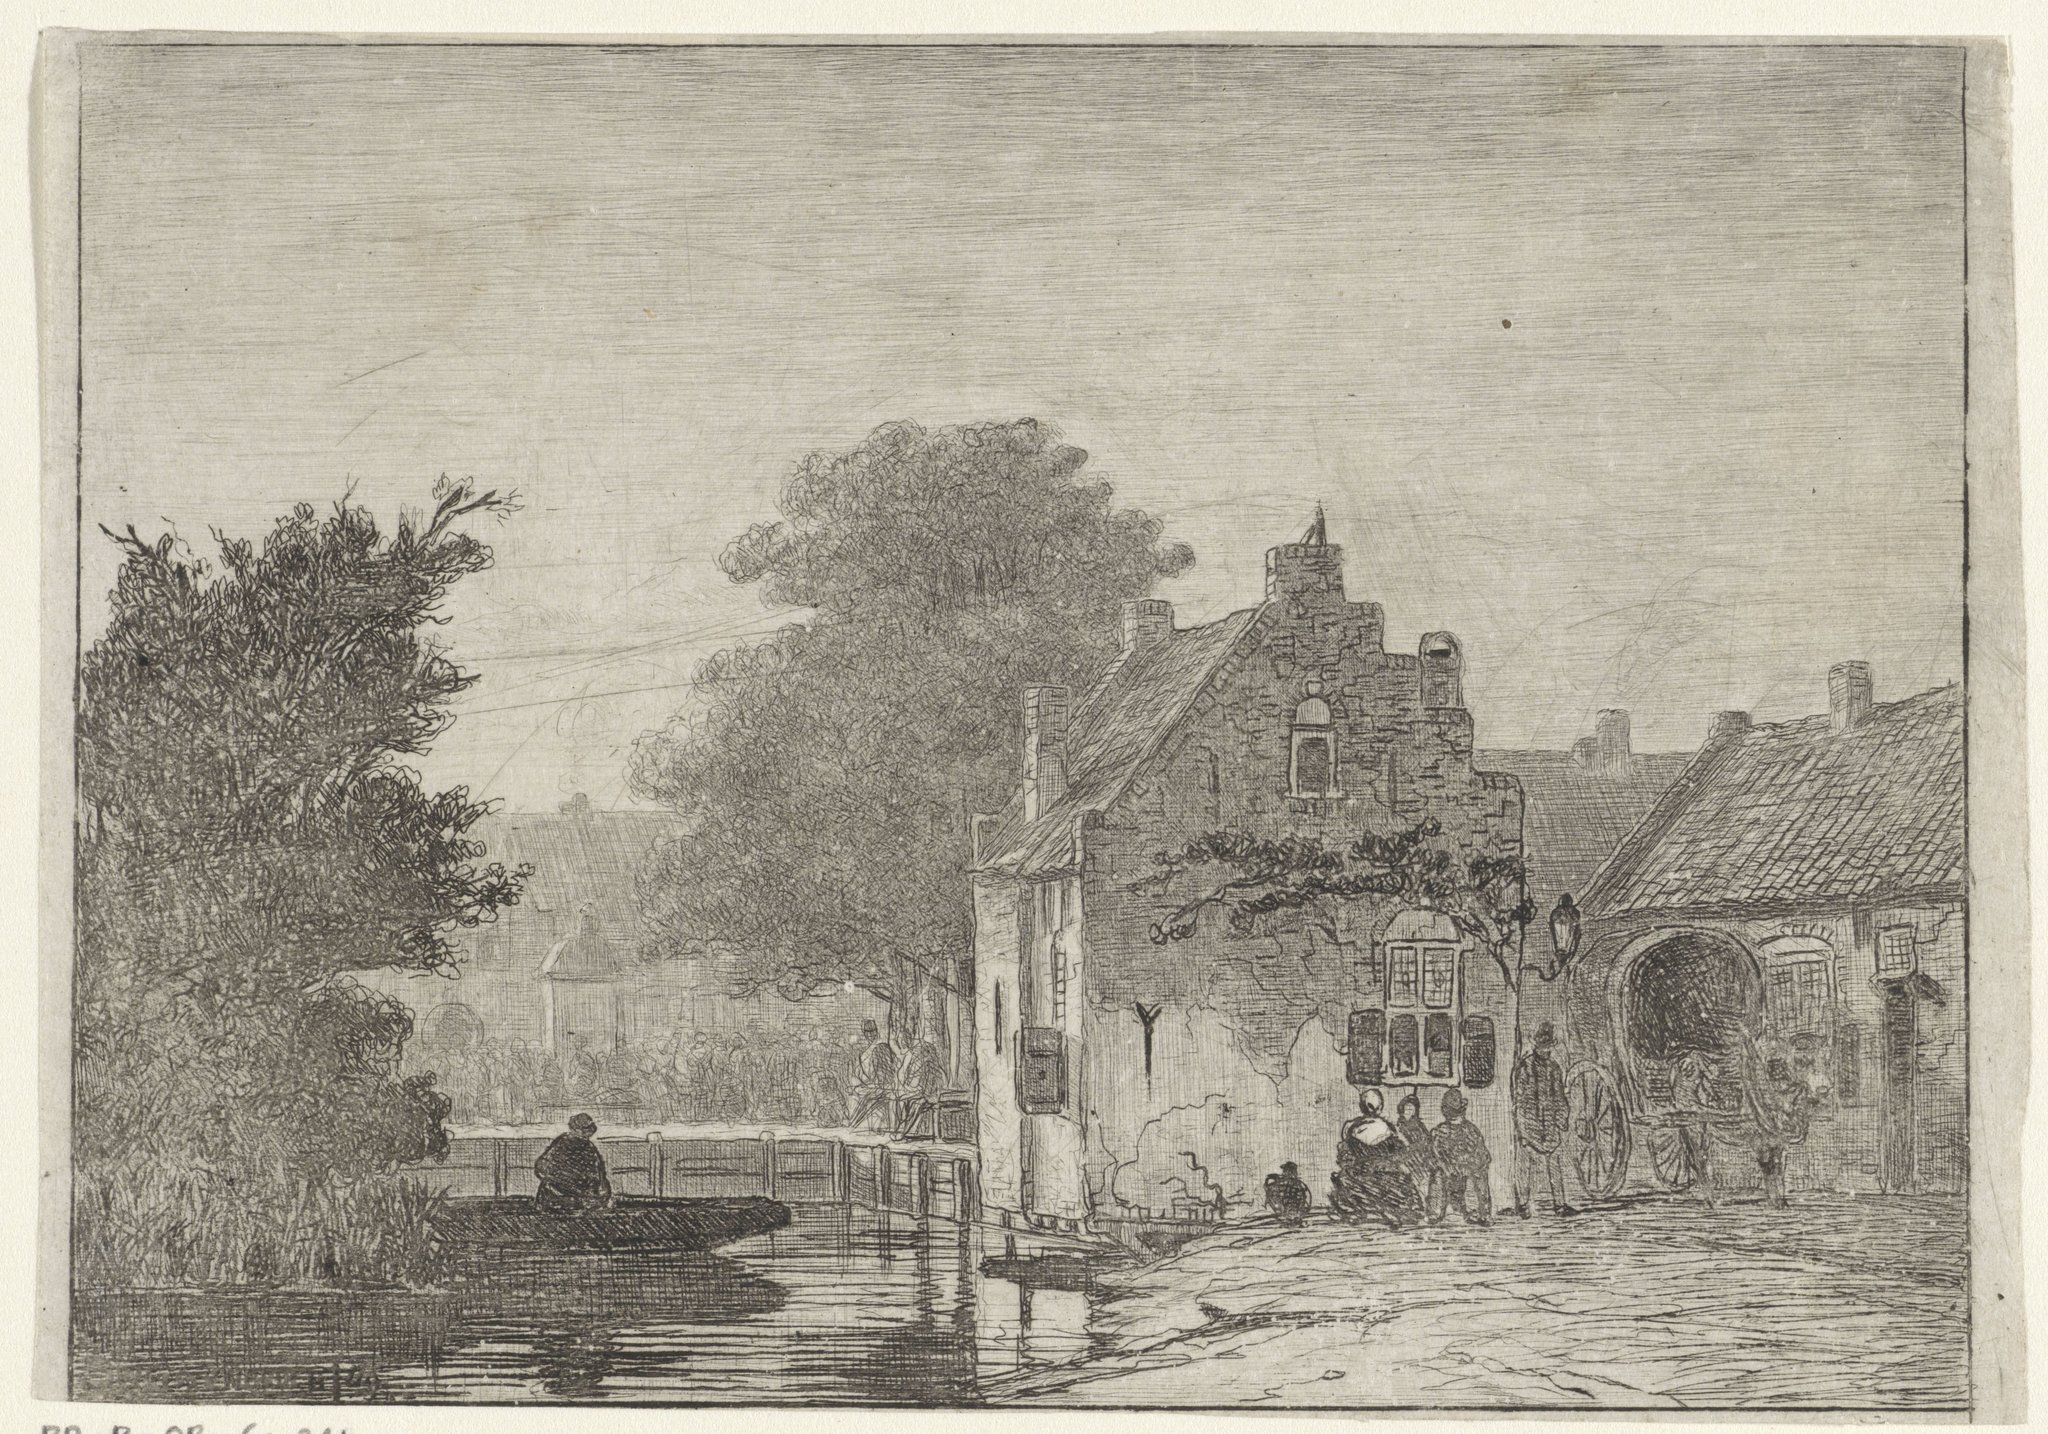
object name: print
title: Markt te Boxtel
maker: jan weissenbruch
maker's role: painter, print maker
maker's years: 1822-1880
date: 1849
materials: paper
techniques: etching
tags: urban housing, city-view, and landscape with man-made constructions, trees, adult woman, adult man, canal, rowing-boat, canoe, etc., horse, market, (farm) wagon, freight wagon, cart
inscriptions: date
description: In de verte is een druk marktplein te zien. Links vaart een man in een boot over een klein kanaal. Rechts zitten enkele figuren voor een huis met een trapgevel. Op de weg ernaast staat een paard-en-wagen.